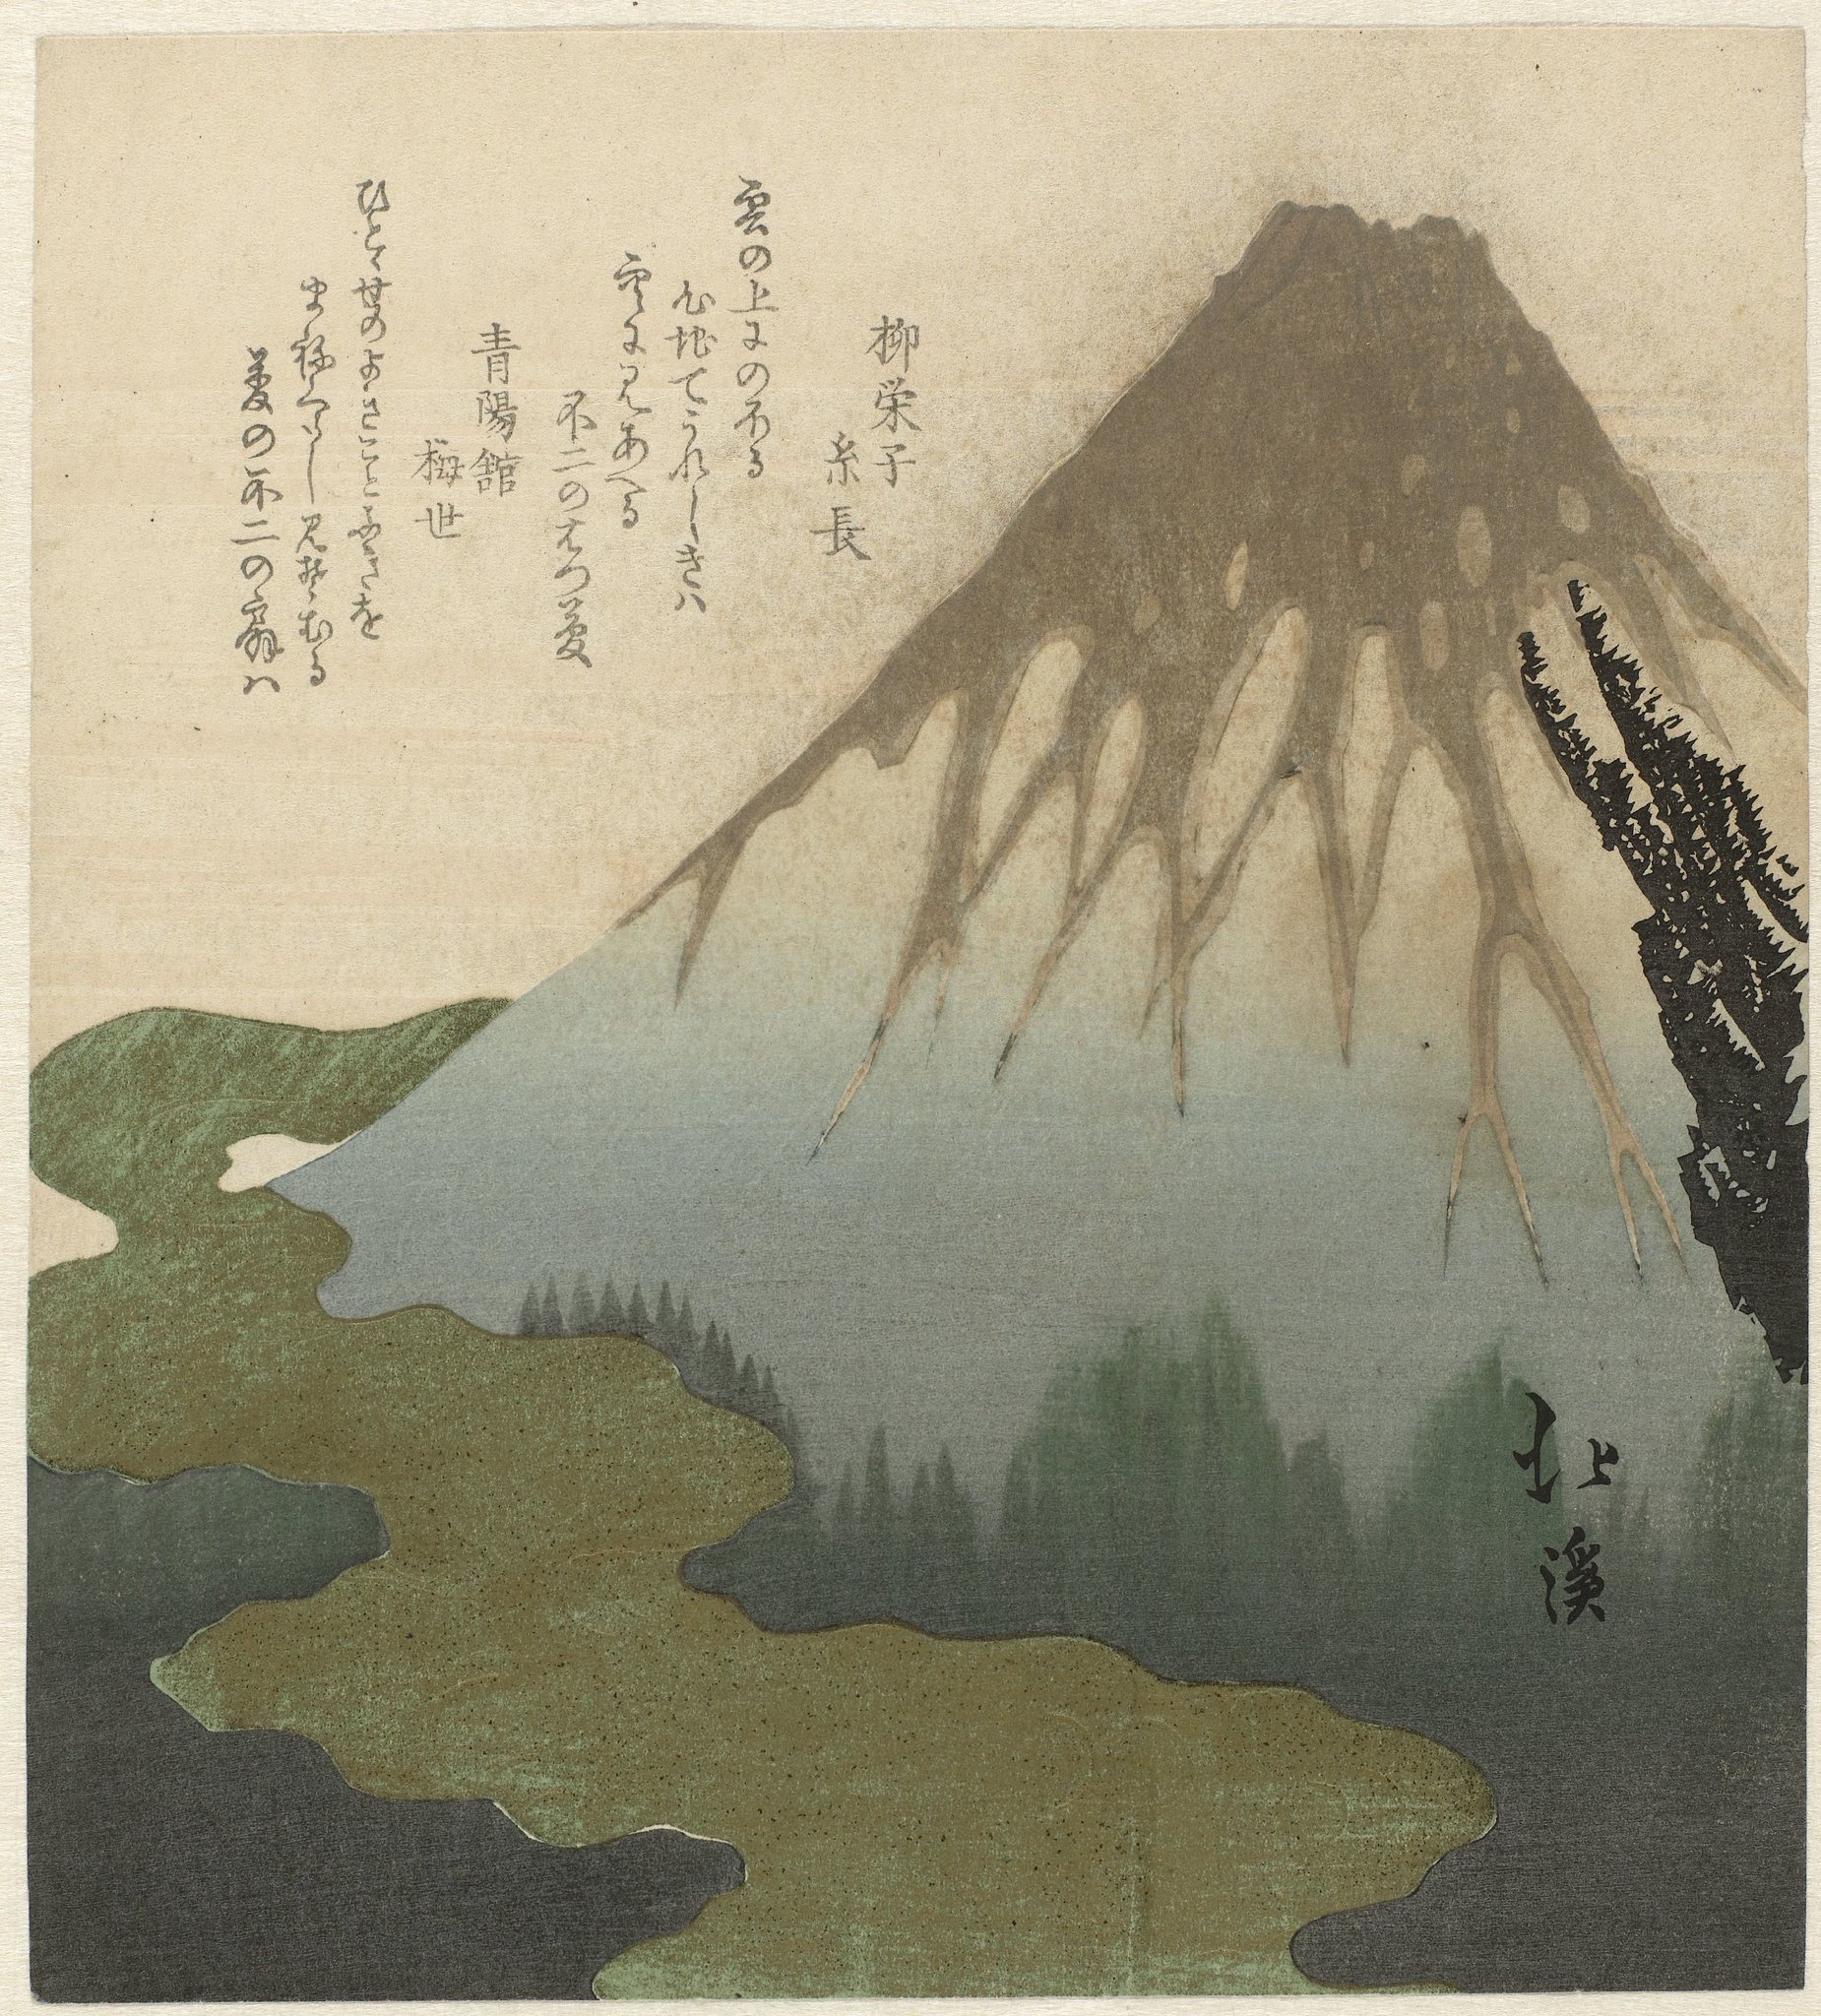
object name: print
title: Fuji boven de wolken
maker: totoya hokkei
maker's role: print maker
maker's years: 1790-1850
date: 1890-1900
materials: paper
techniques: woodcut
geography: japan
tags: mountain-top, peak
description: Een surimono is een luxe uitgevoerde prent waarop beeld met één of meerdere gedichten gecombineerd is. Bij het drukken van een surimono werd vaak gebruik gemaakt van dikker papier, blinddruk en metaal pigmenten, zoals koper- en zilverpoeder. De prenten werden vaak in opdracht van dichters gemaakt en als exclusief geschenk aan vrienden en relaties gegeven.